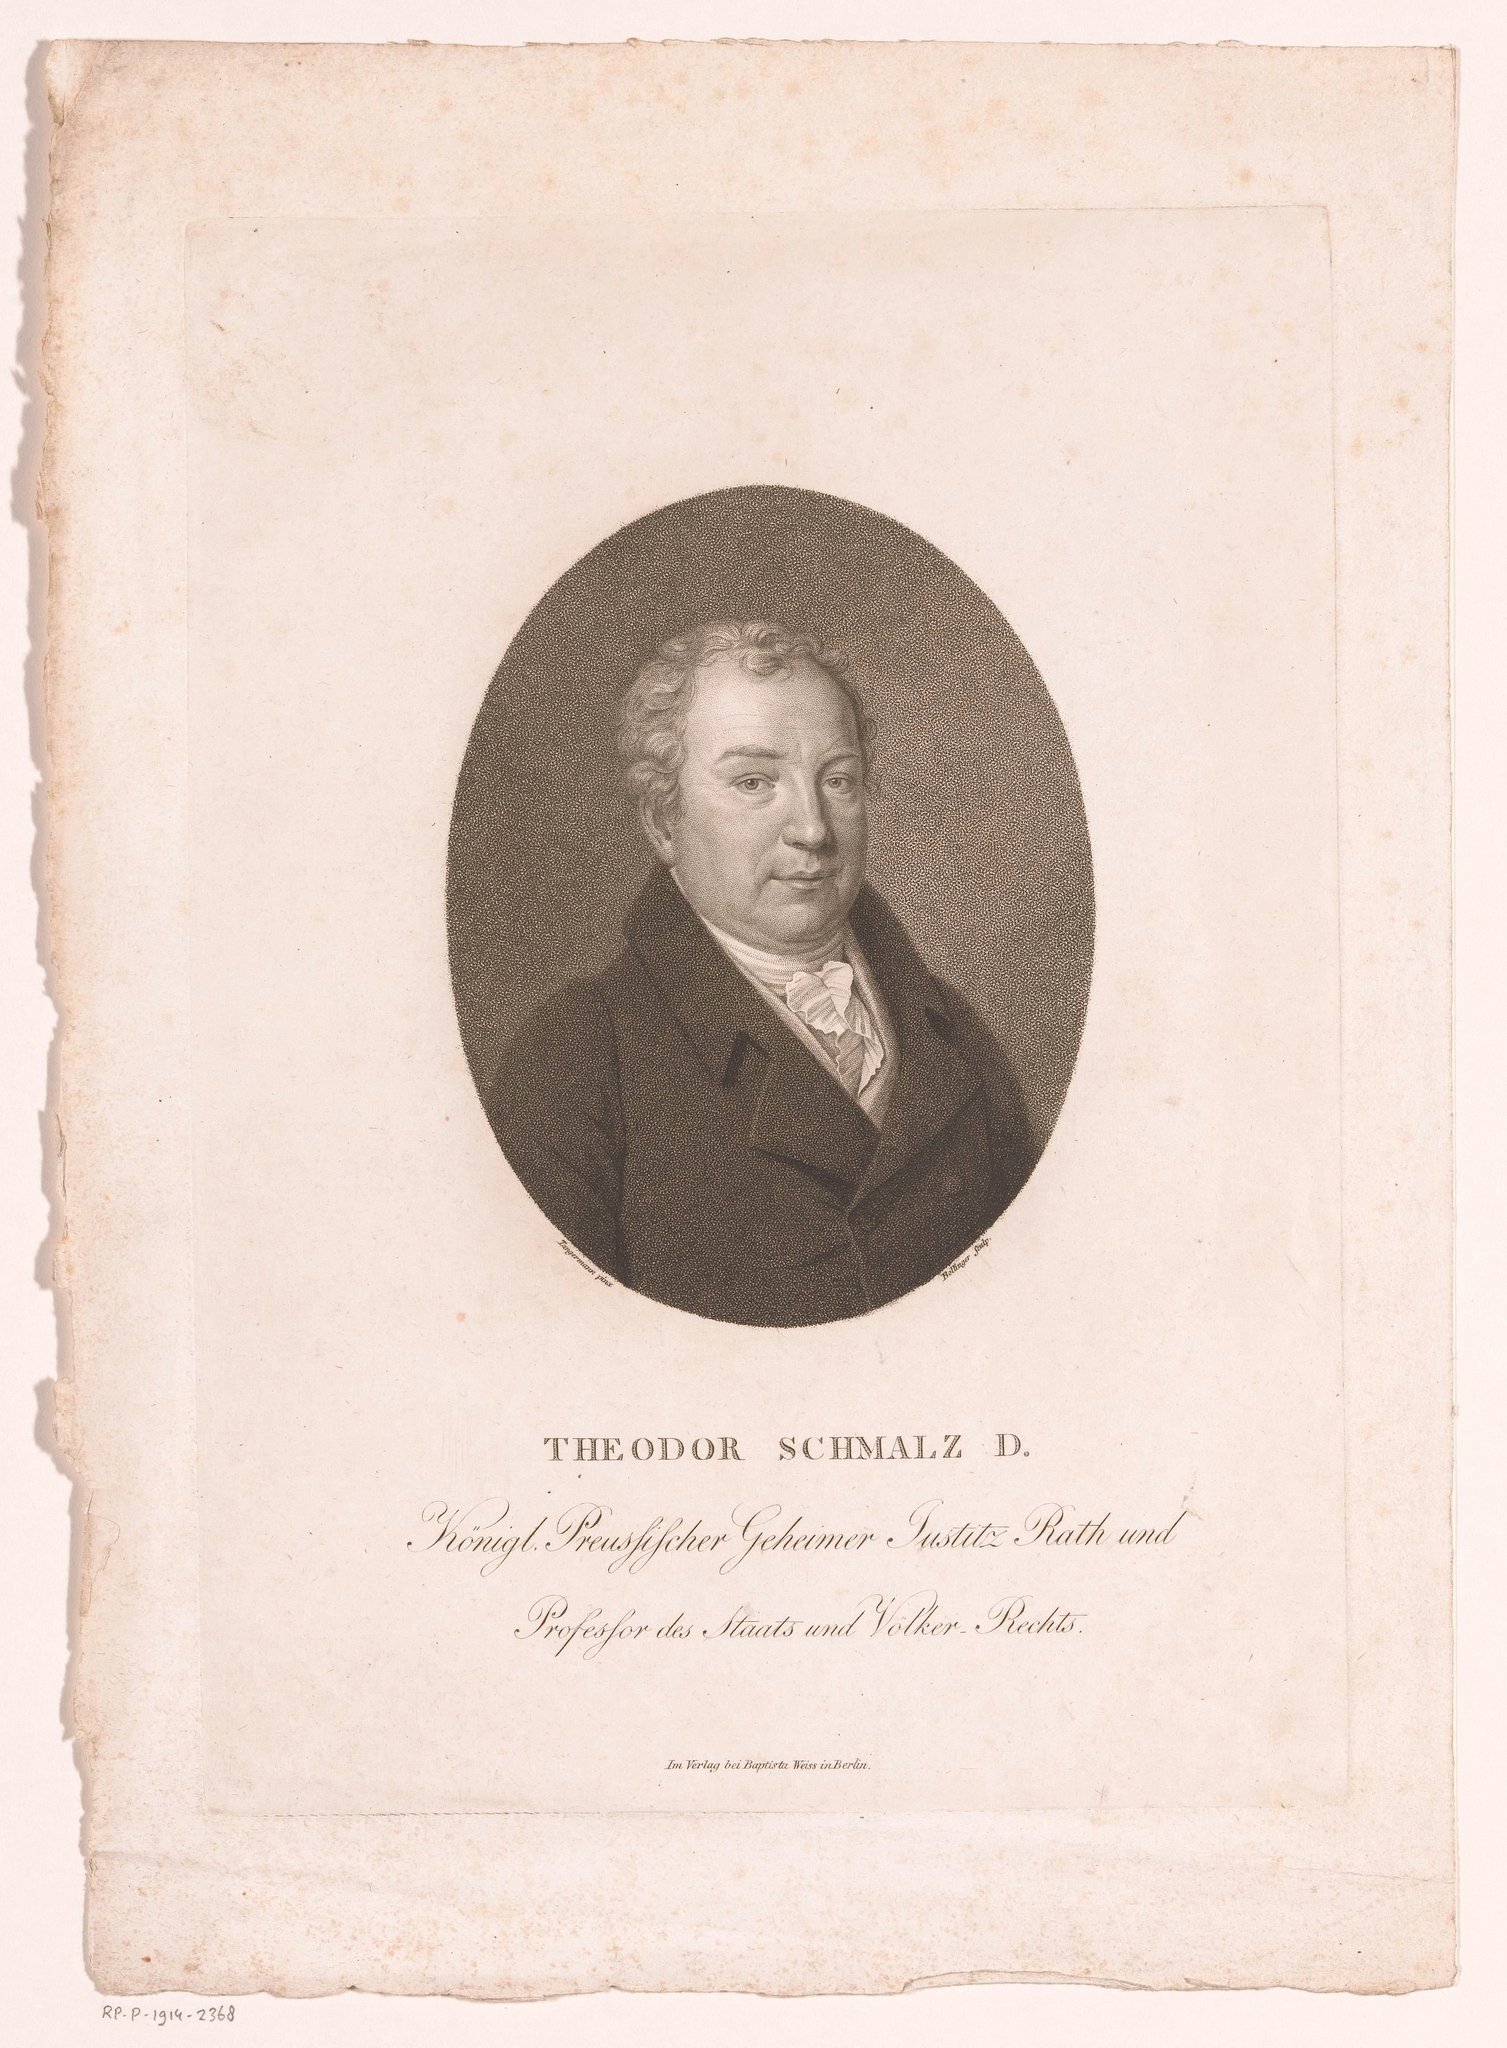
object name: print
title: Portret van Theodor Schmalz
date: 1803-1825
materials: paper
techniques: stippling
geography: berlin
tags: historical persons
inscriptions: collector's mark: Lugt 2228